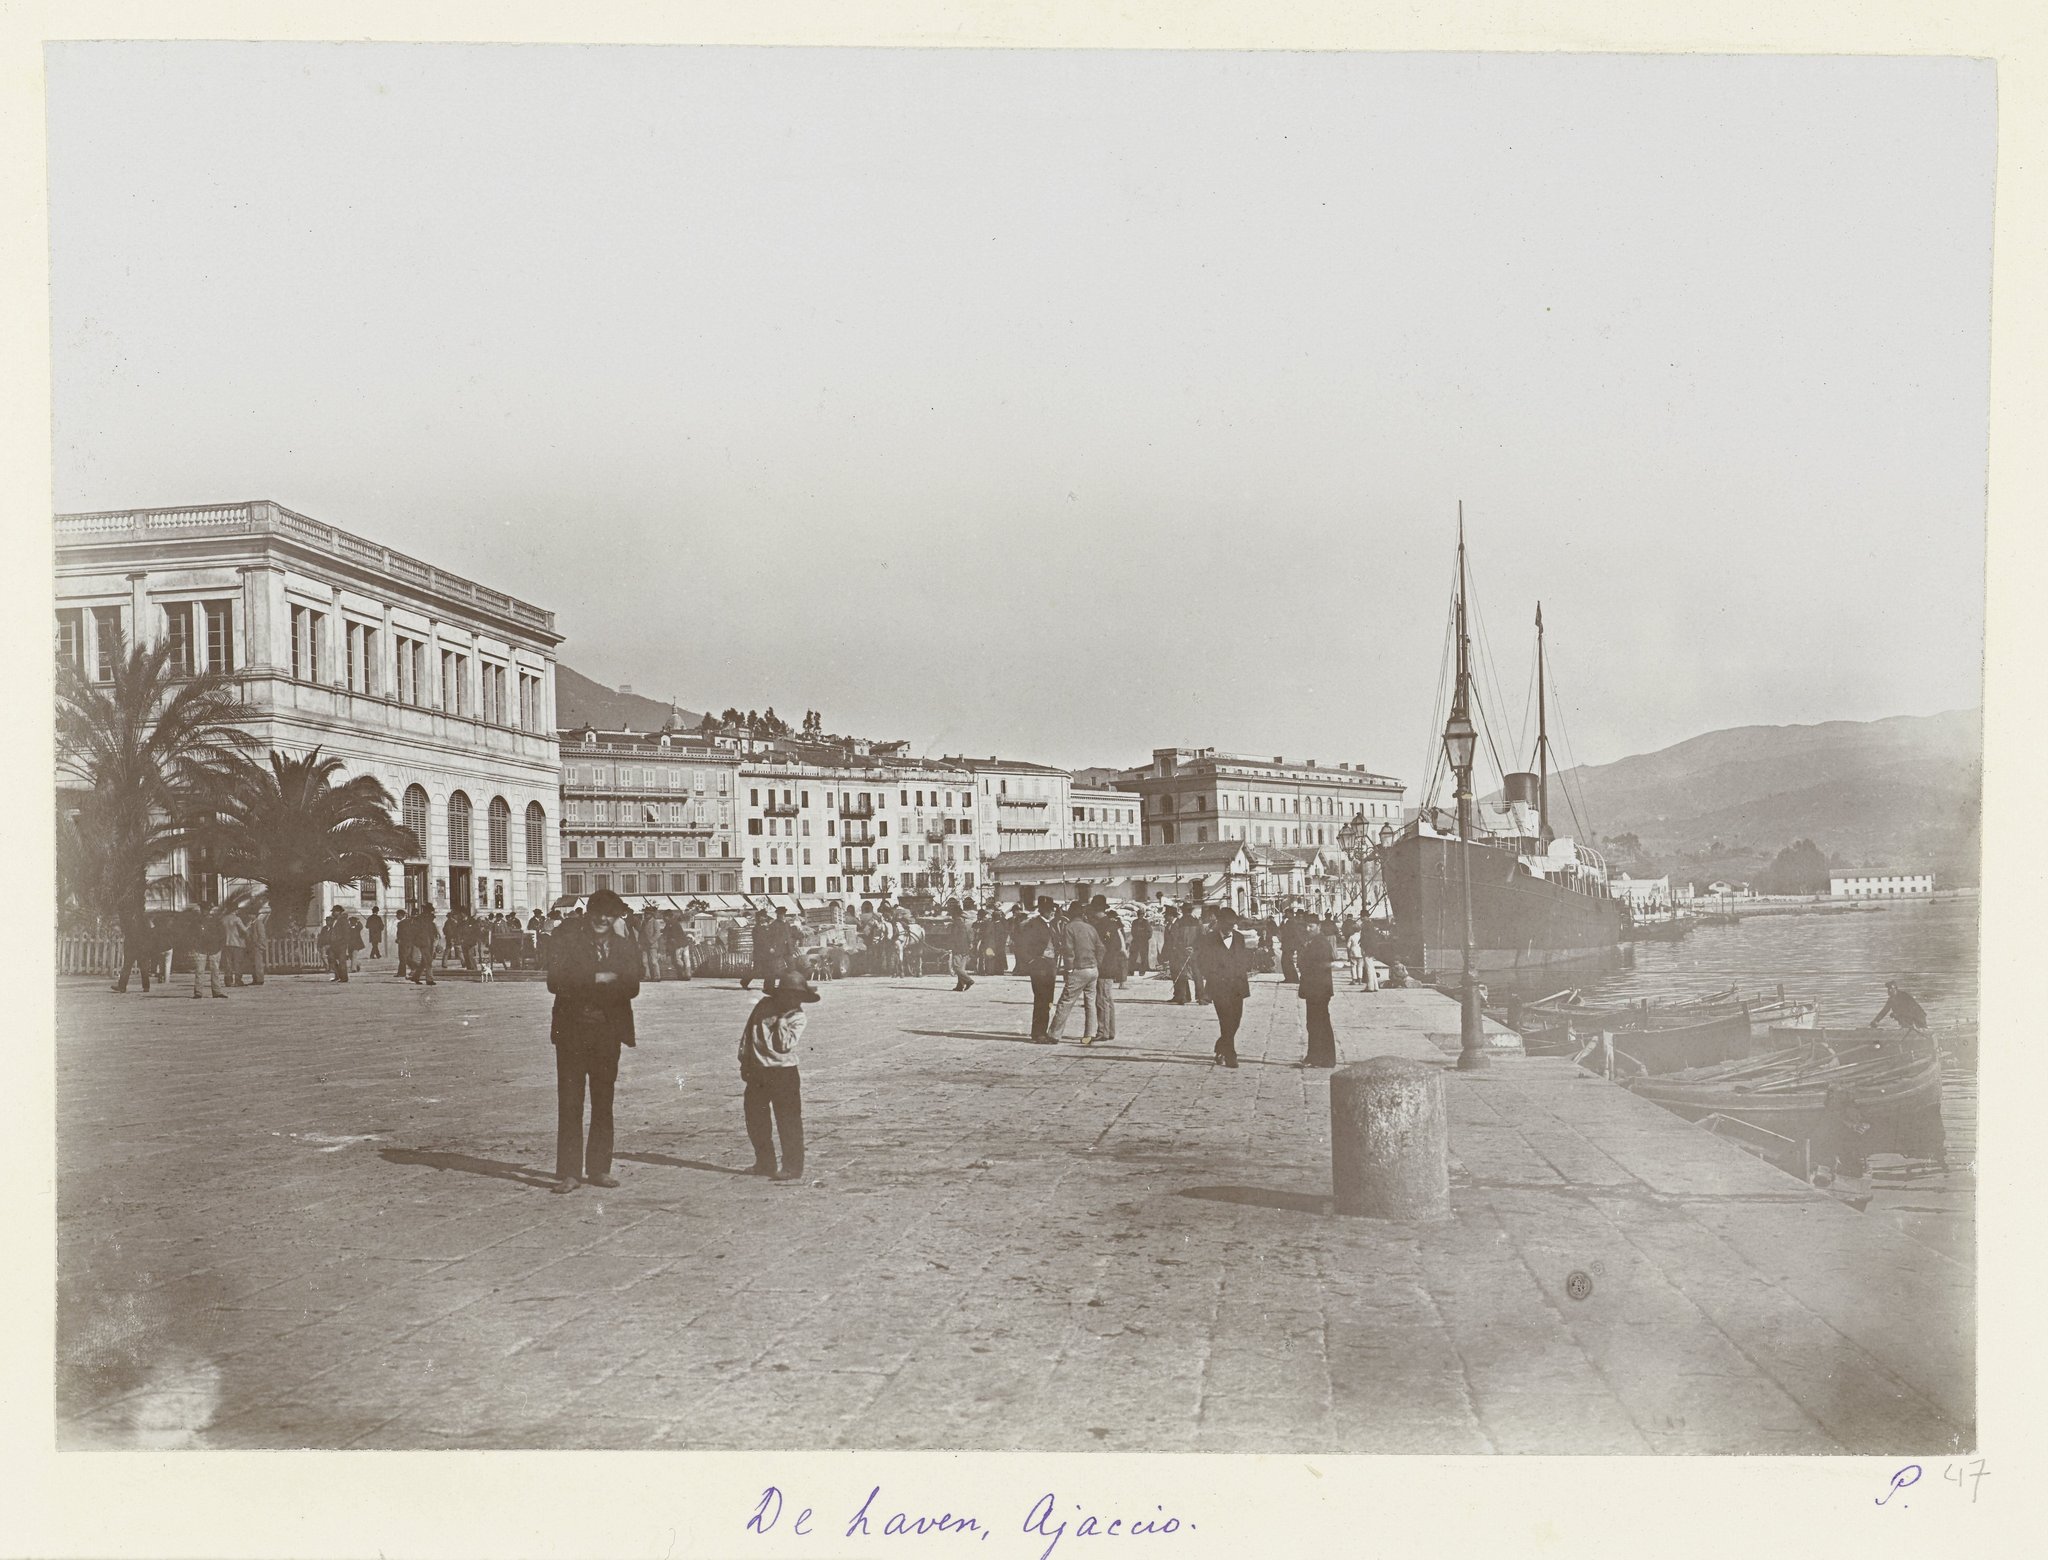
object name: photograph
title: Haven en promenade van Ajaccio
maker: henry pauw van wieldrecht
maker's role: fotograaf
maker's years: 1863-1912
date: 1886-1896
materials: cardboard, photographic support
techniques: albumen print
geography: corsica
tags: ajaccio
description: De haven van Ajaccio waar veel mensen lopen. Aan de linkerkant gebouwen aan de rechterkant het water van de haven met boten.